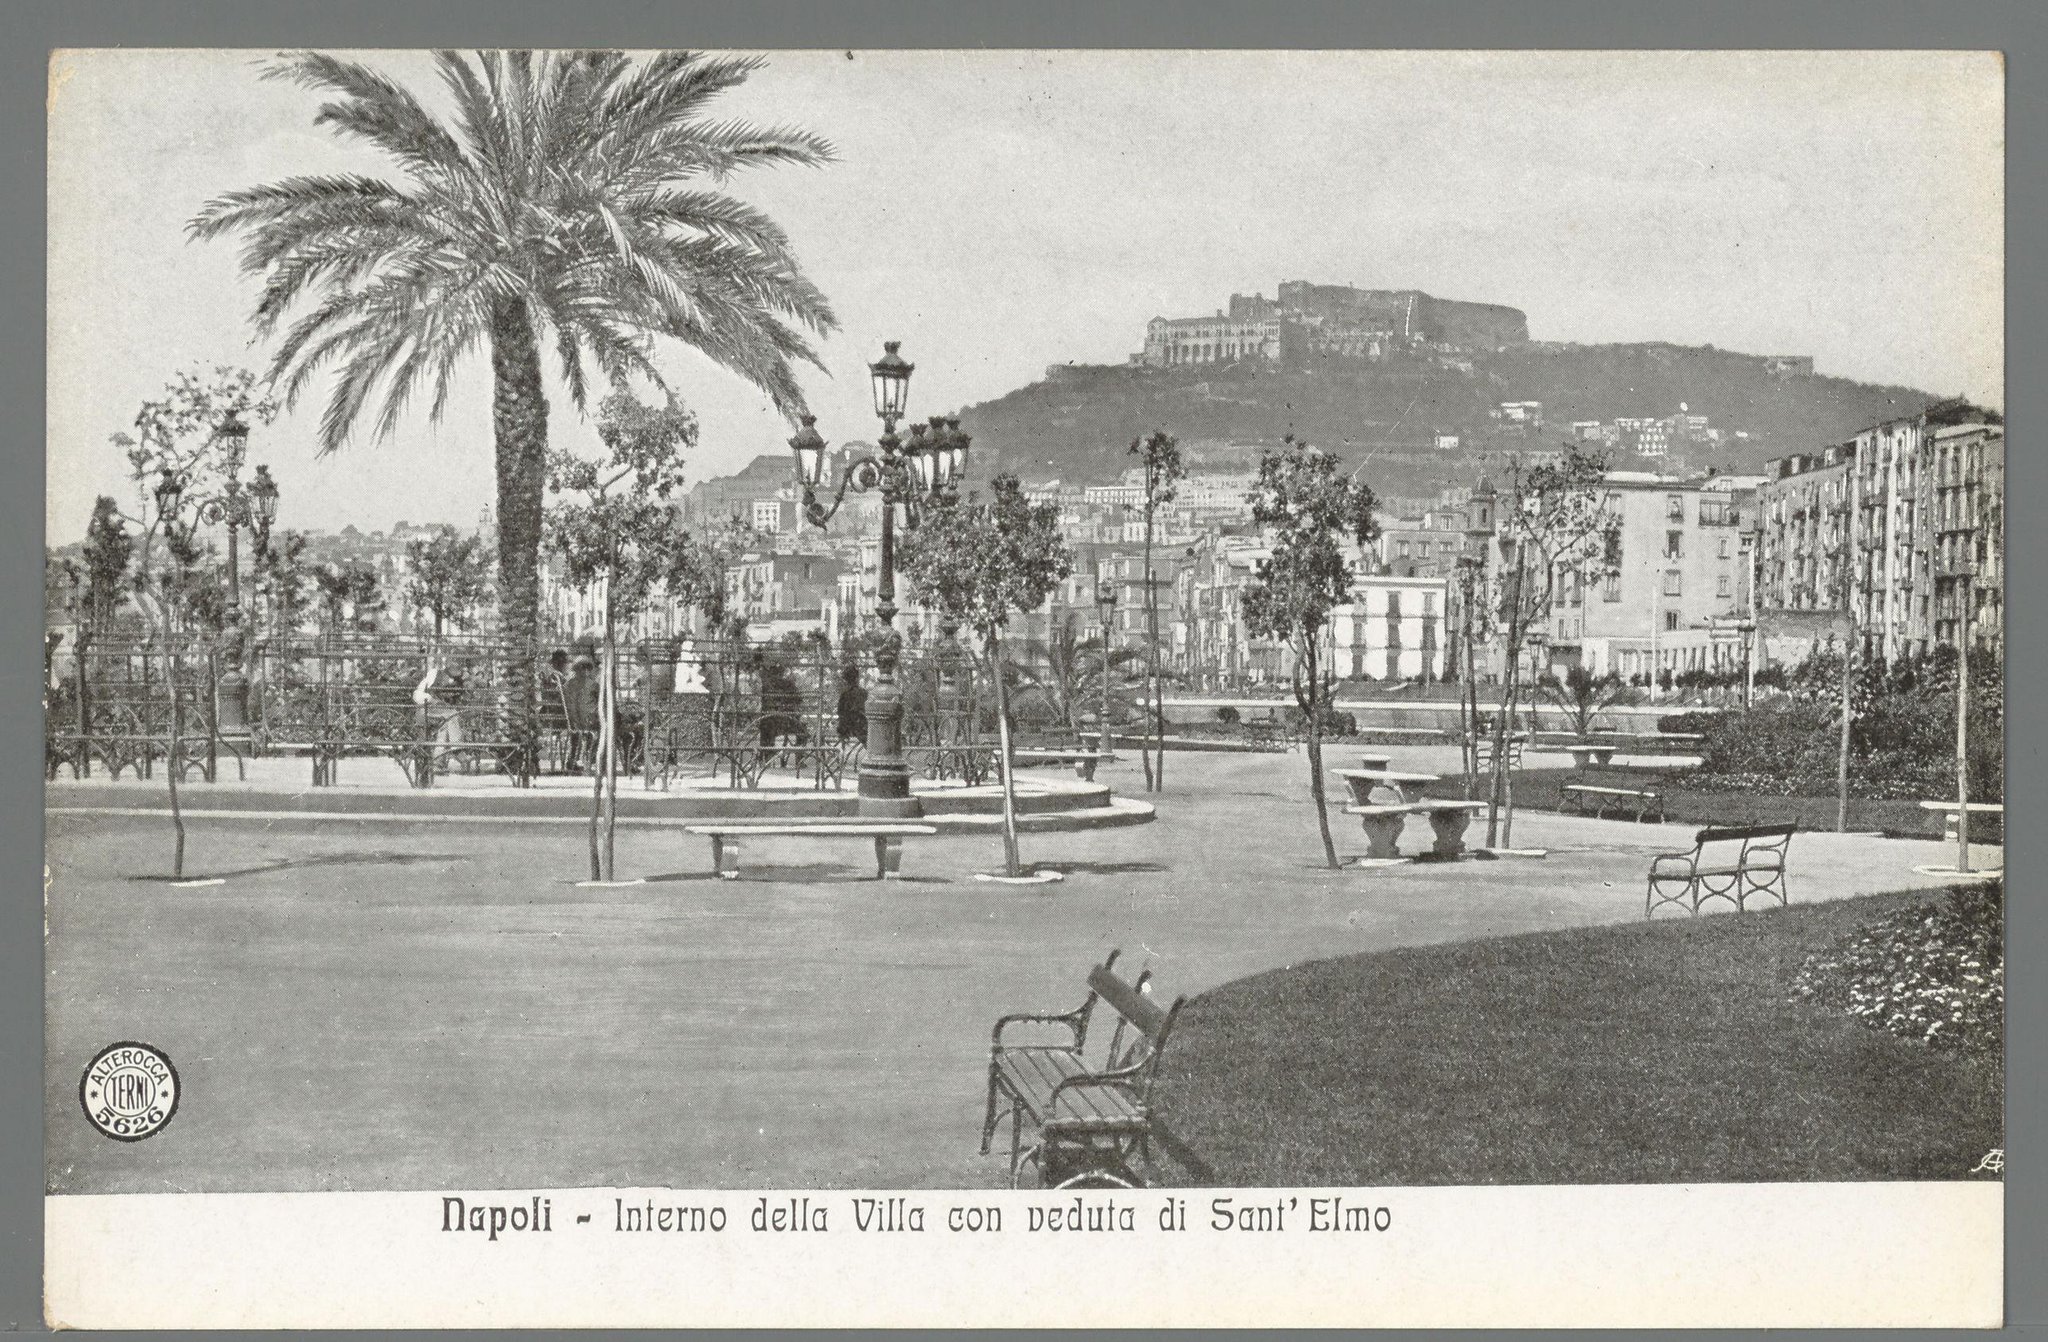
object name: photomechanical print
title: Napoli. Interno della Villa con veduta di Sant'Elmo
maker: Anonymous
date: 1906-1910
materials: cardboard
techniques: autotype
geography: terni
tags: square, place, circus, etc., (high) hill, naples